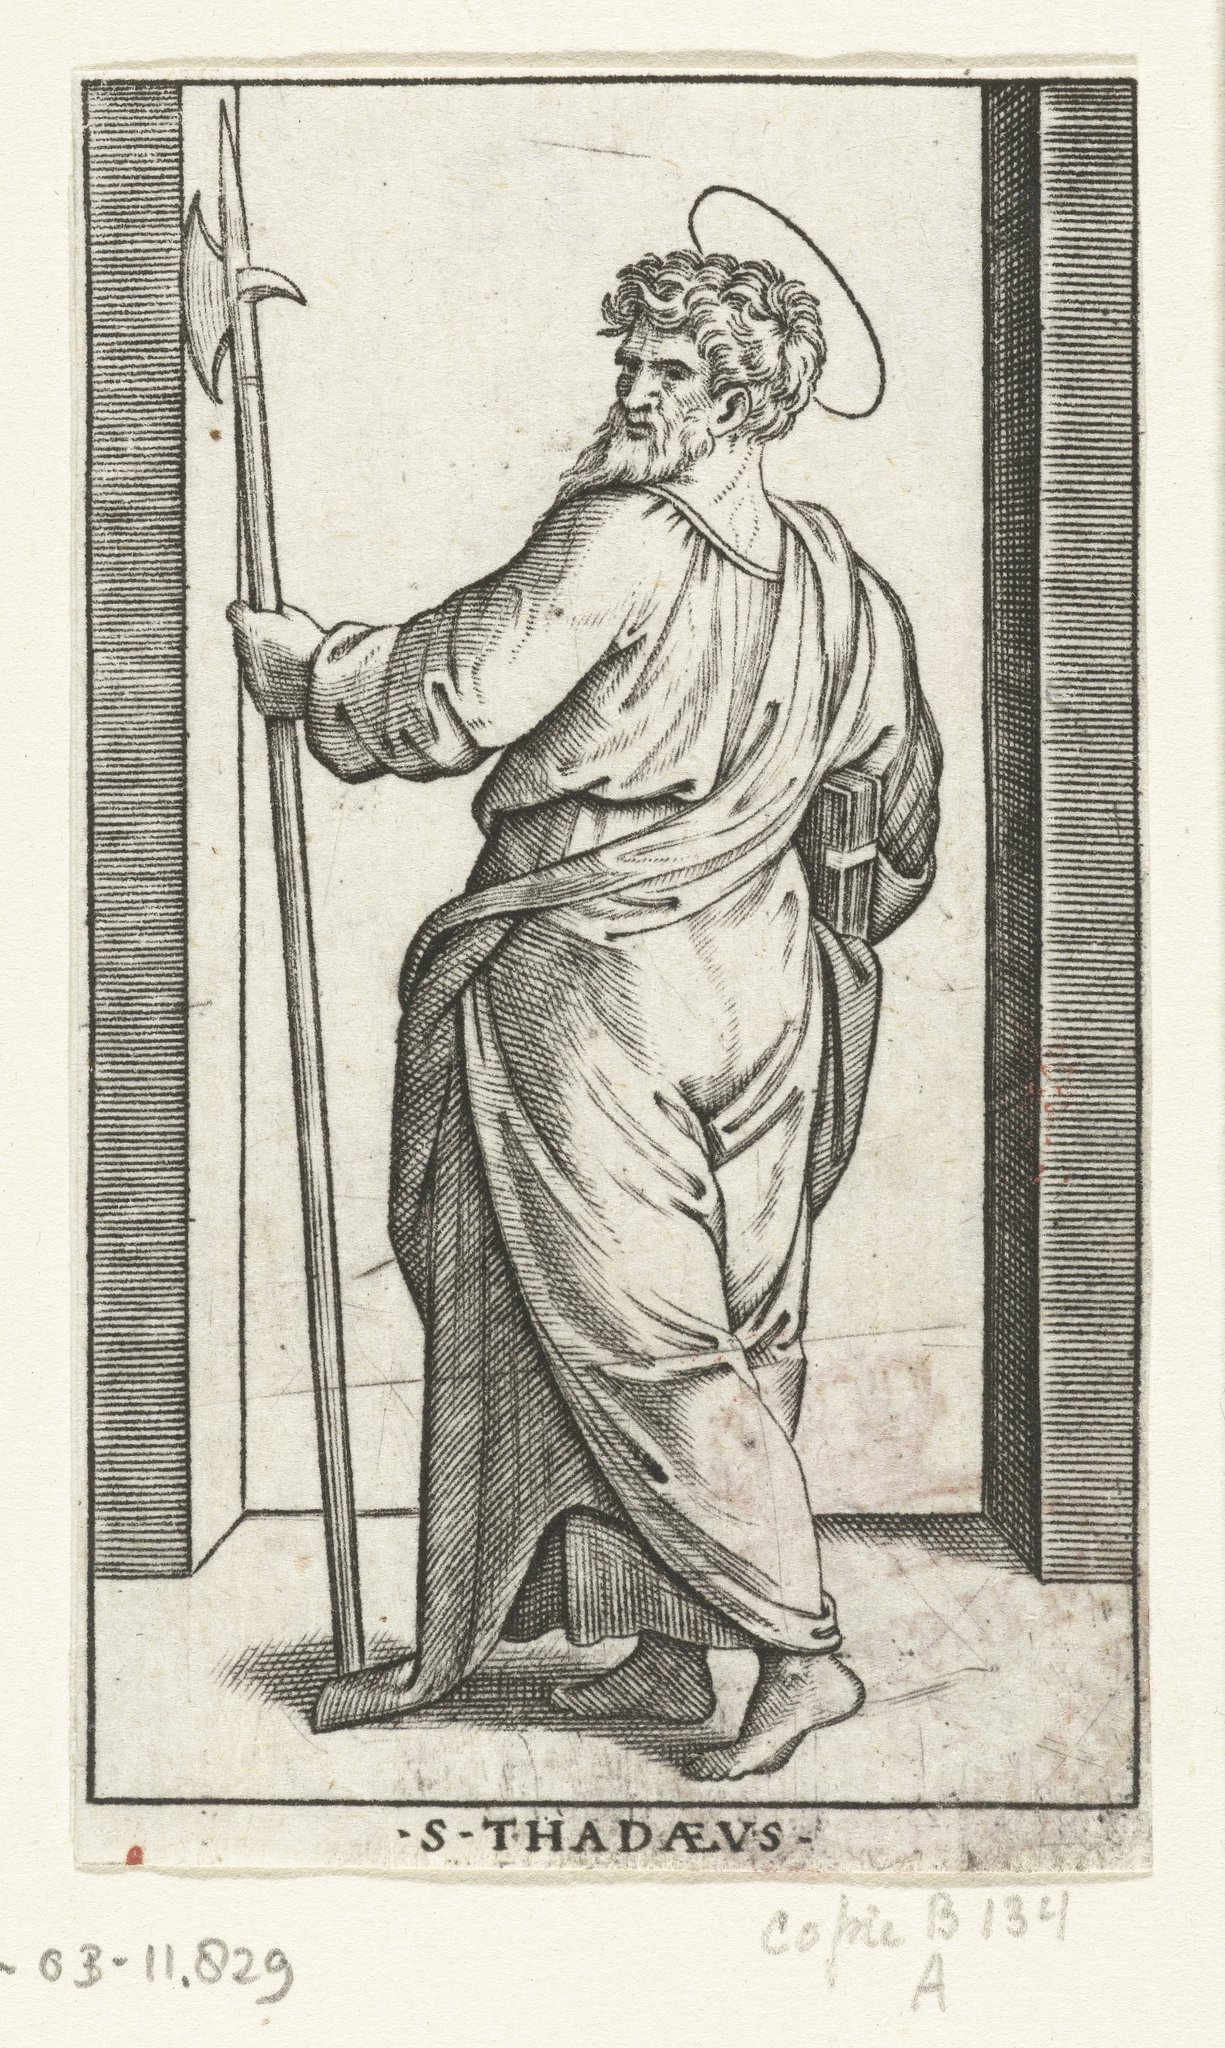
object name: print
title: Apostel Judas Taddeüs met hellebaard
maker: Anonymous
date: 1517-1527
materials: paper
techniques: engraving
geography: italy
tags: the apostle jude thaddaeus; possible attributes: book, club, halberd, scroll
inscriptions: collector's mark: Lugt 12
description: Kopie in spiegelbeeld naar prent van Marcantonio Raimondi. Raimondi vervaardigde een serie van dertien kleine prenten met Christus en de apostelen naar ontwerp van Raphael.